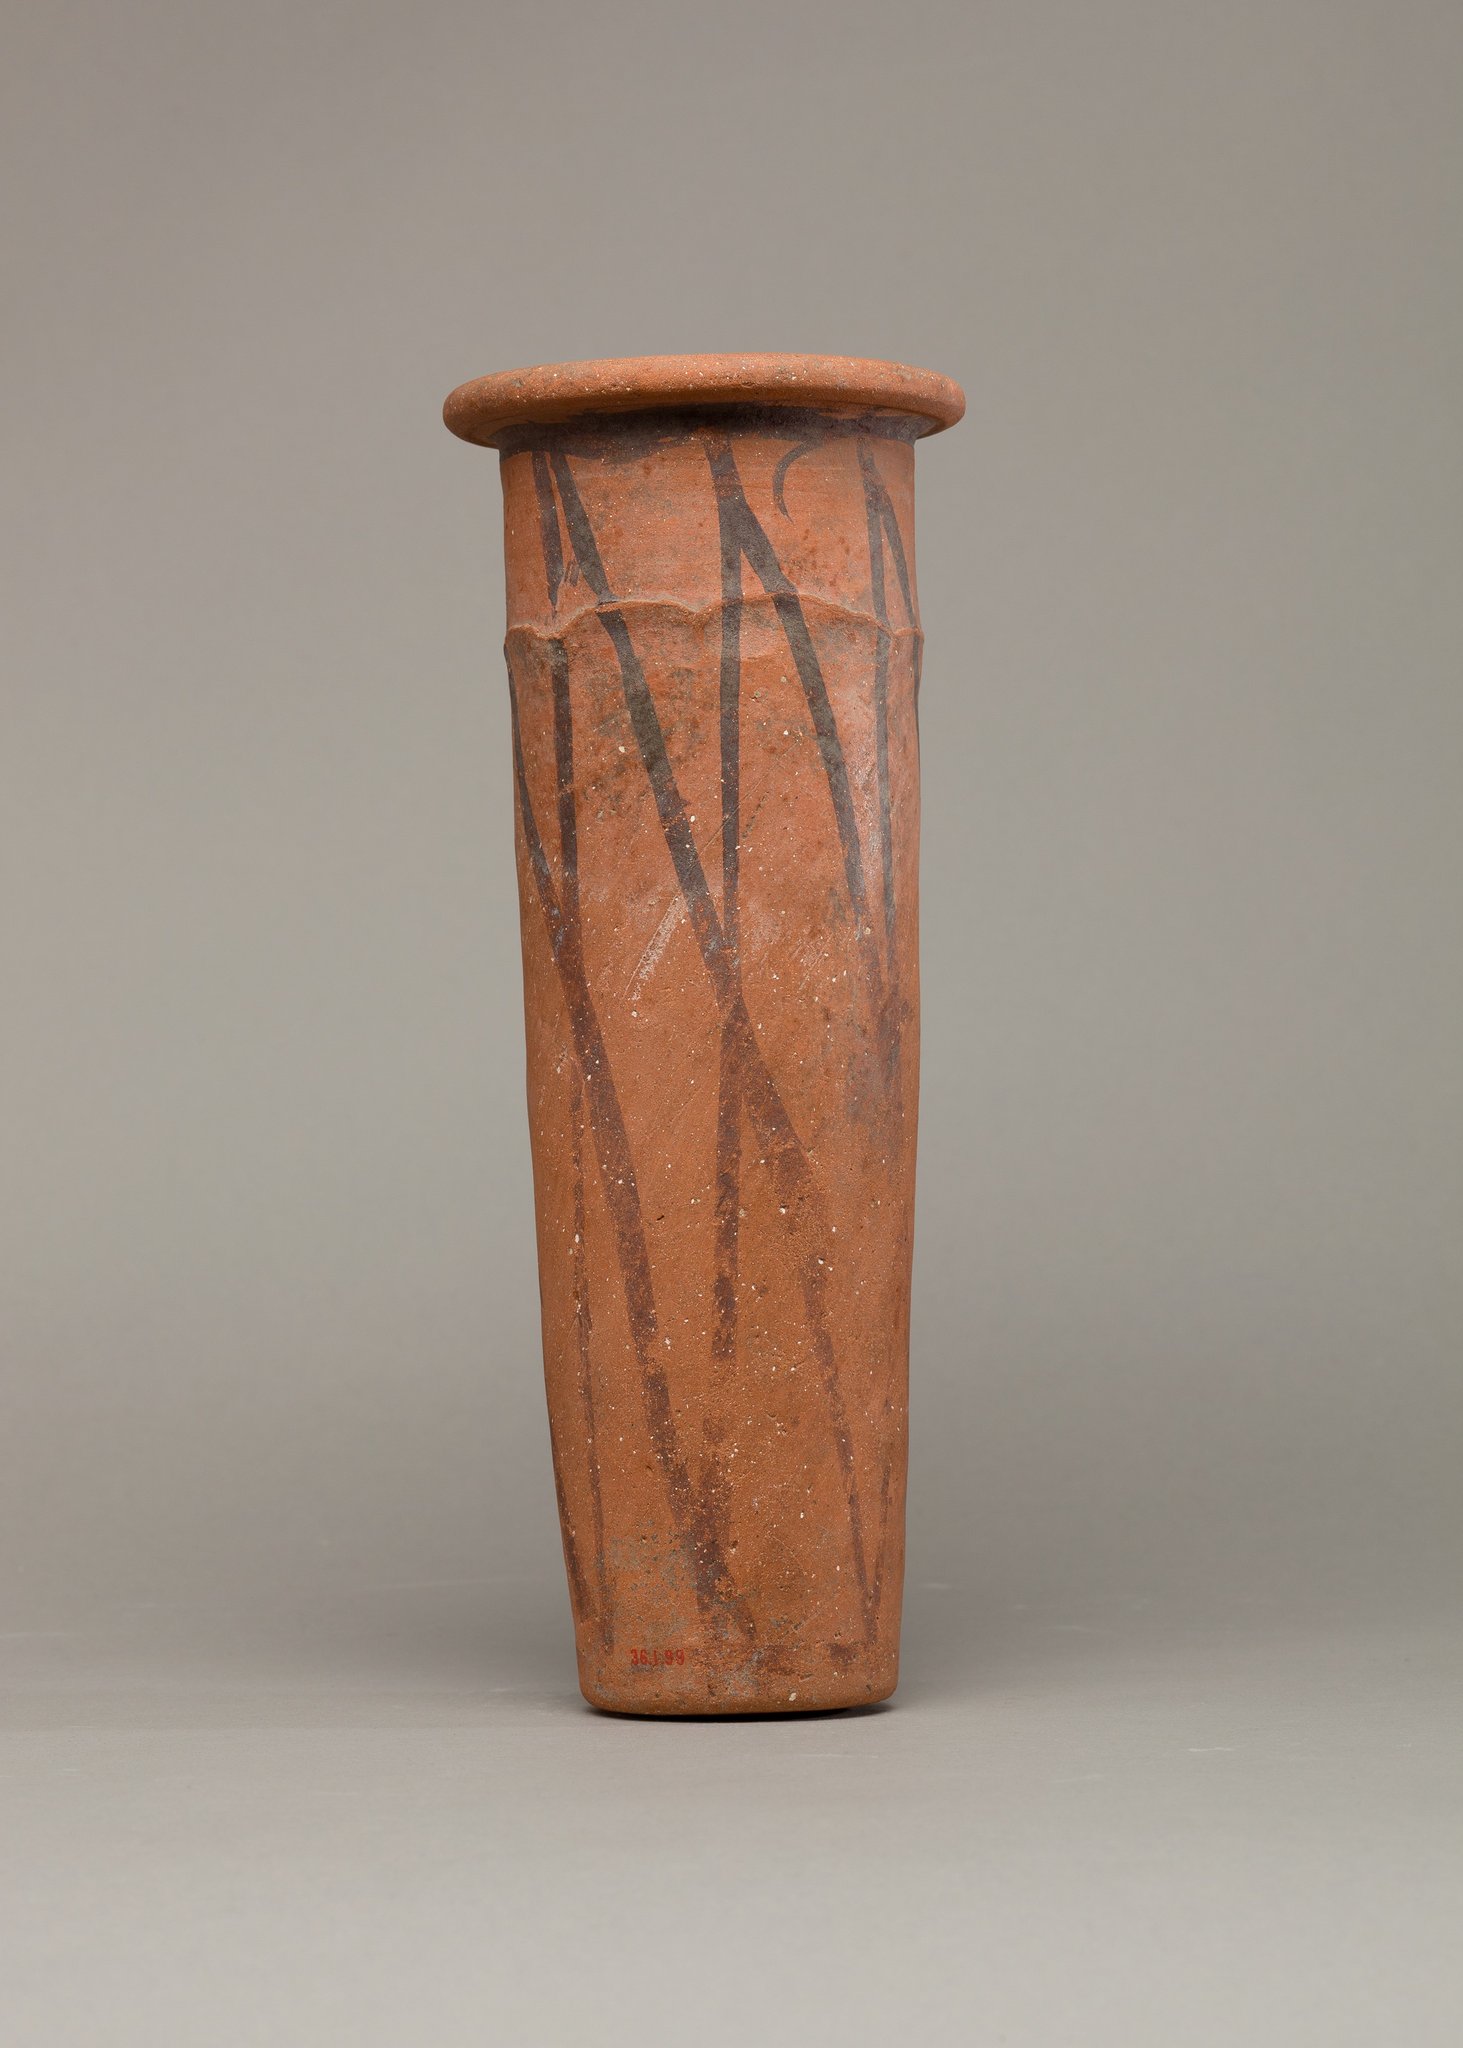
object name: jar, cylindrical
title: Wavy-handled jar with cross-hatched design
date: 4500-4000 BCE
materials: paint, pottery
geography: egypt